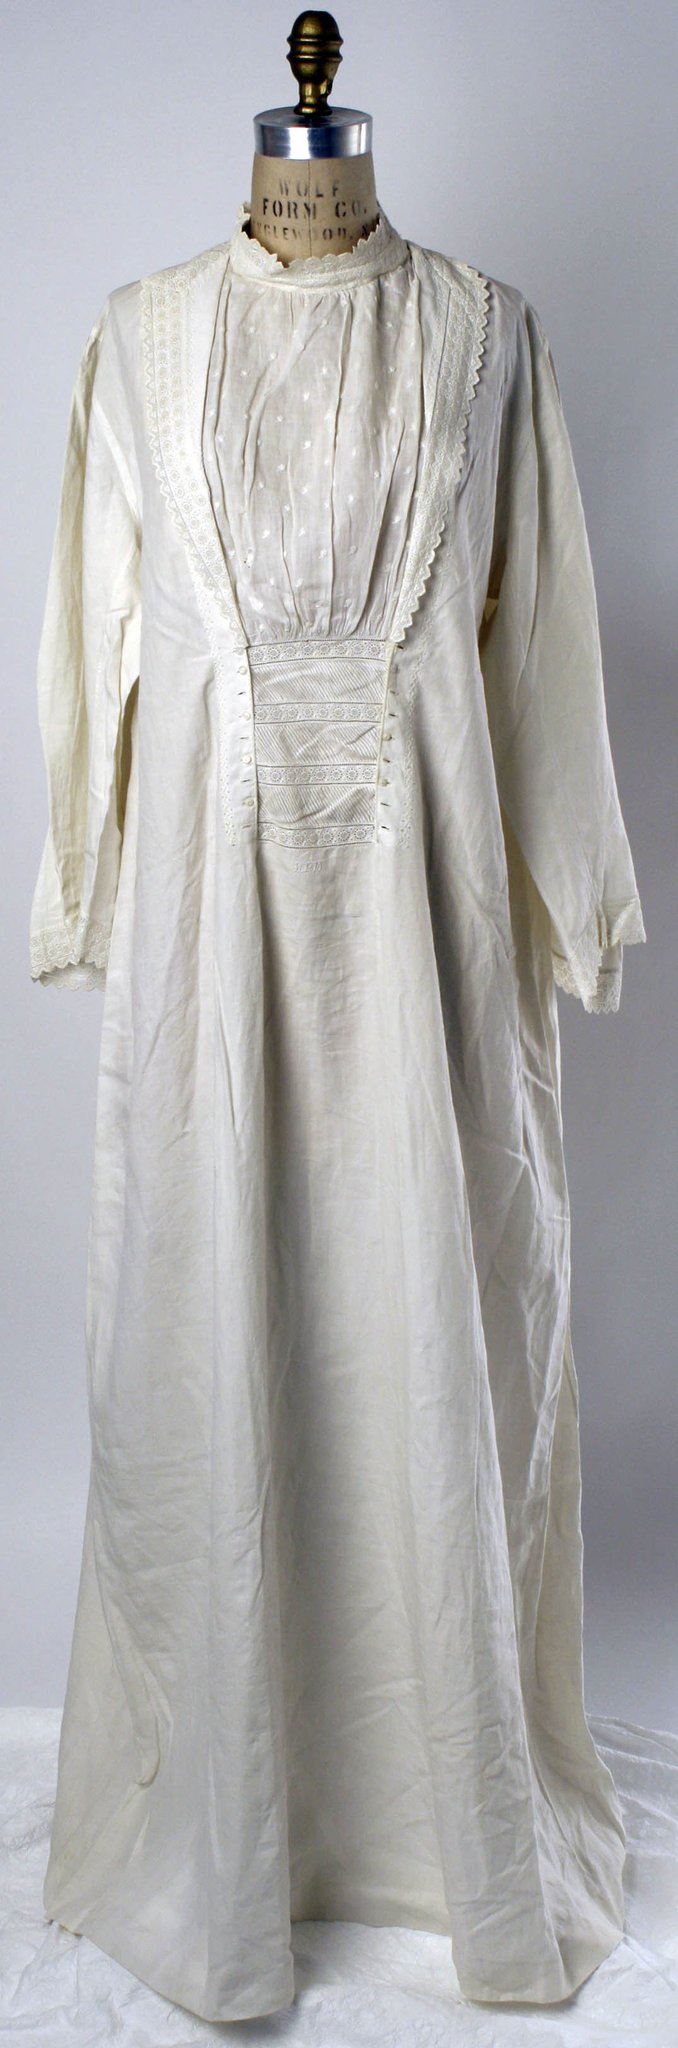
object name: nightgown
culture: american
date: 1870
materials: linen